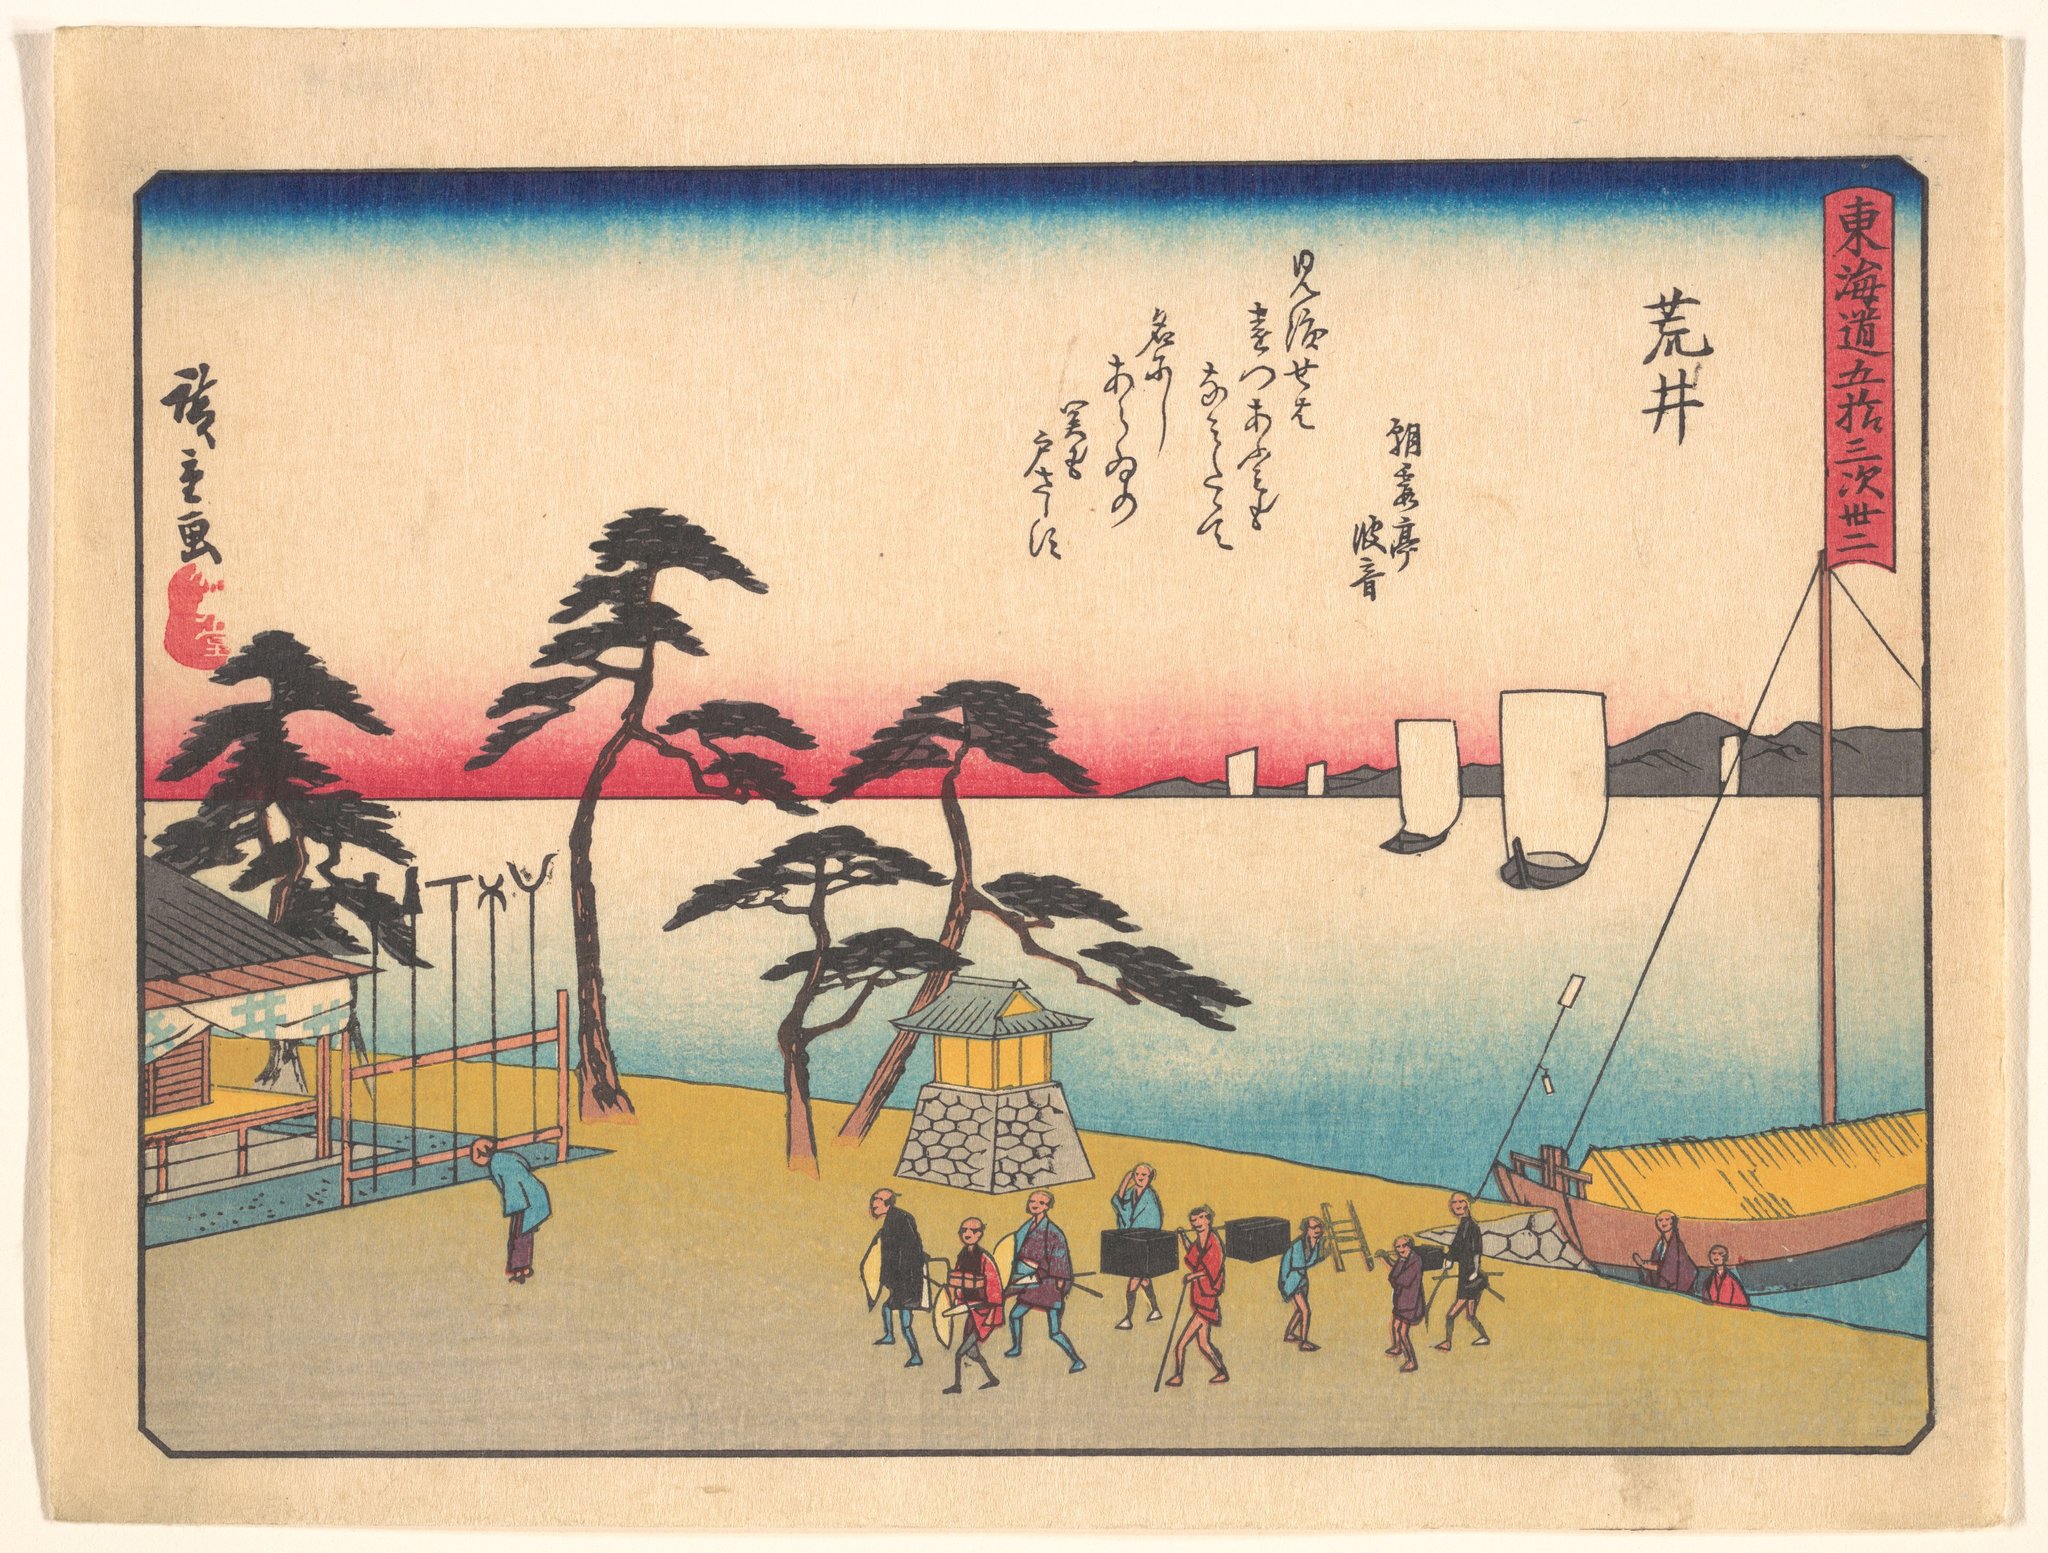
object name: print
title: 東海道五十三次之内 荒井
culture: japanese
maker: utagawa hiroshige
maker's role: artist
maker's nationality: japanese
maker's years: 1797-1858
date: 1901-1933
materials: ink, paper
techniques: woodblock print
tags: human figures,trees,boats